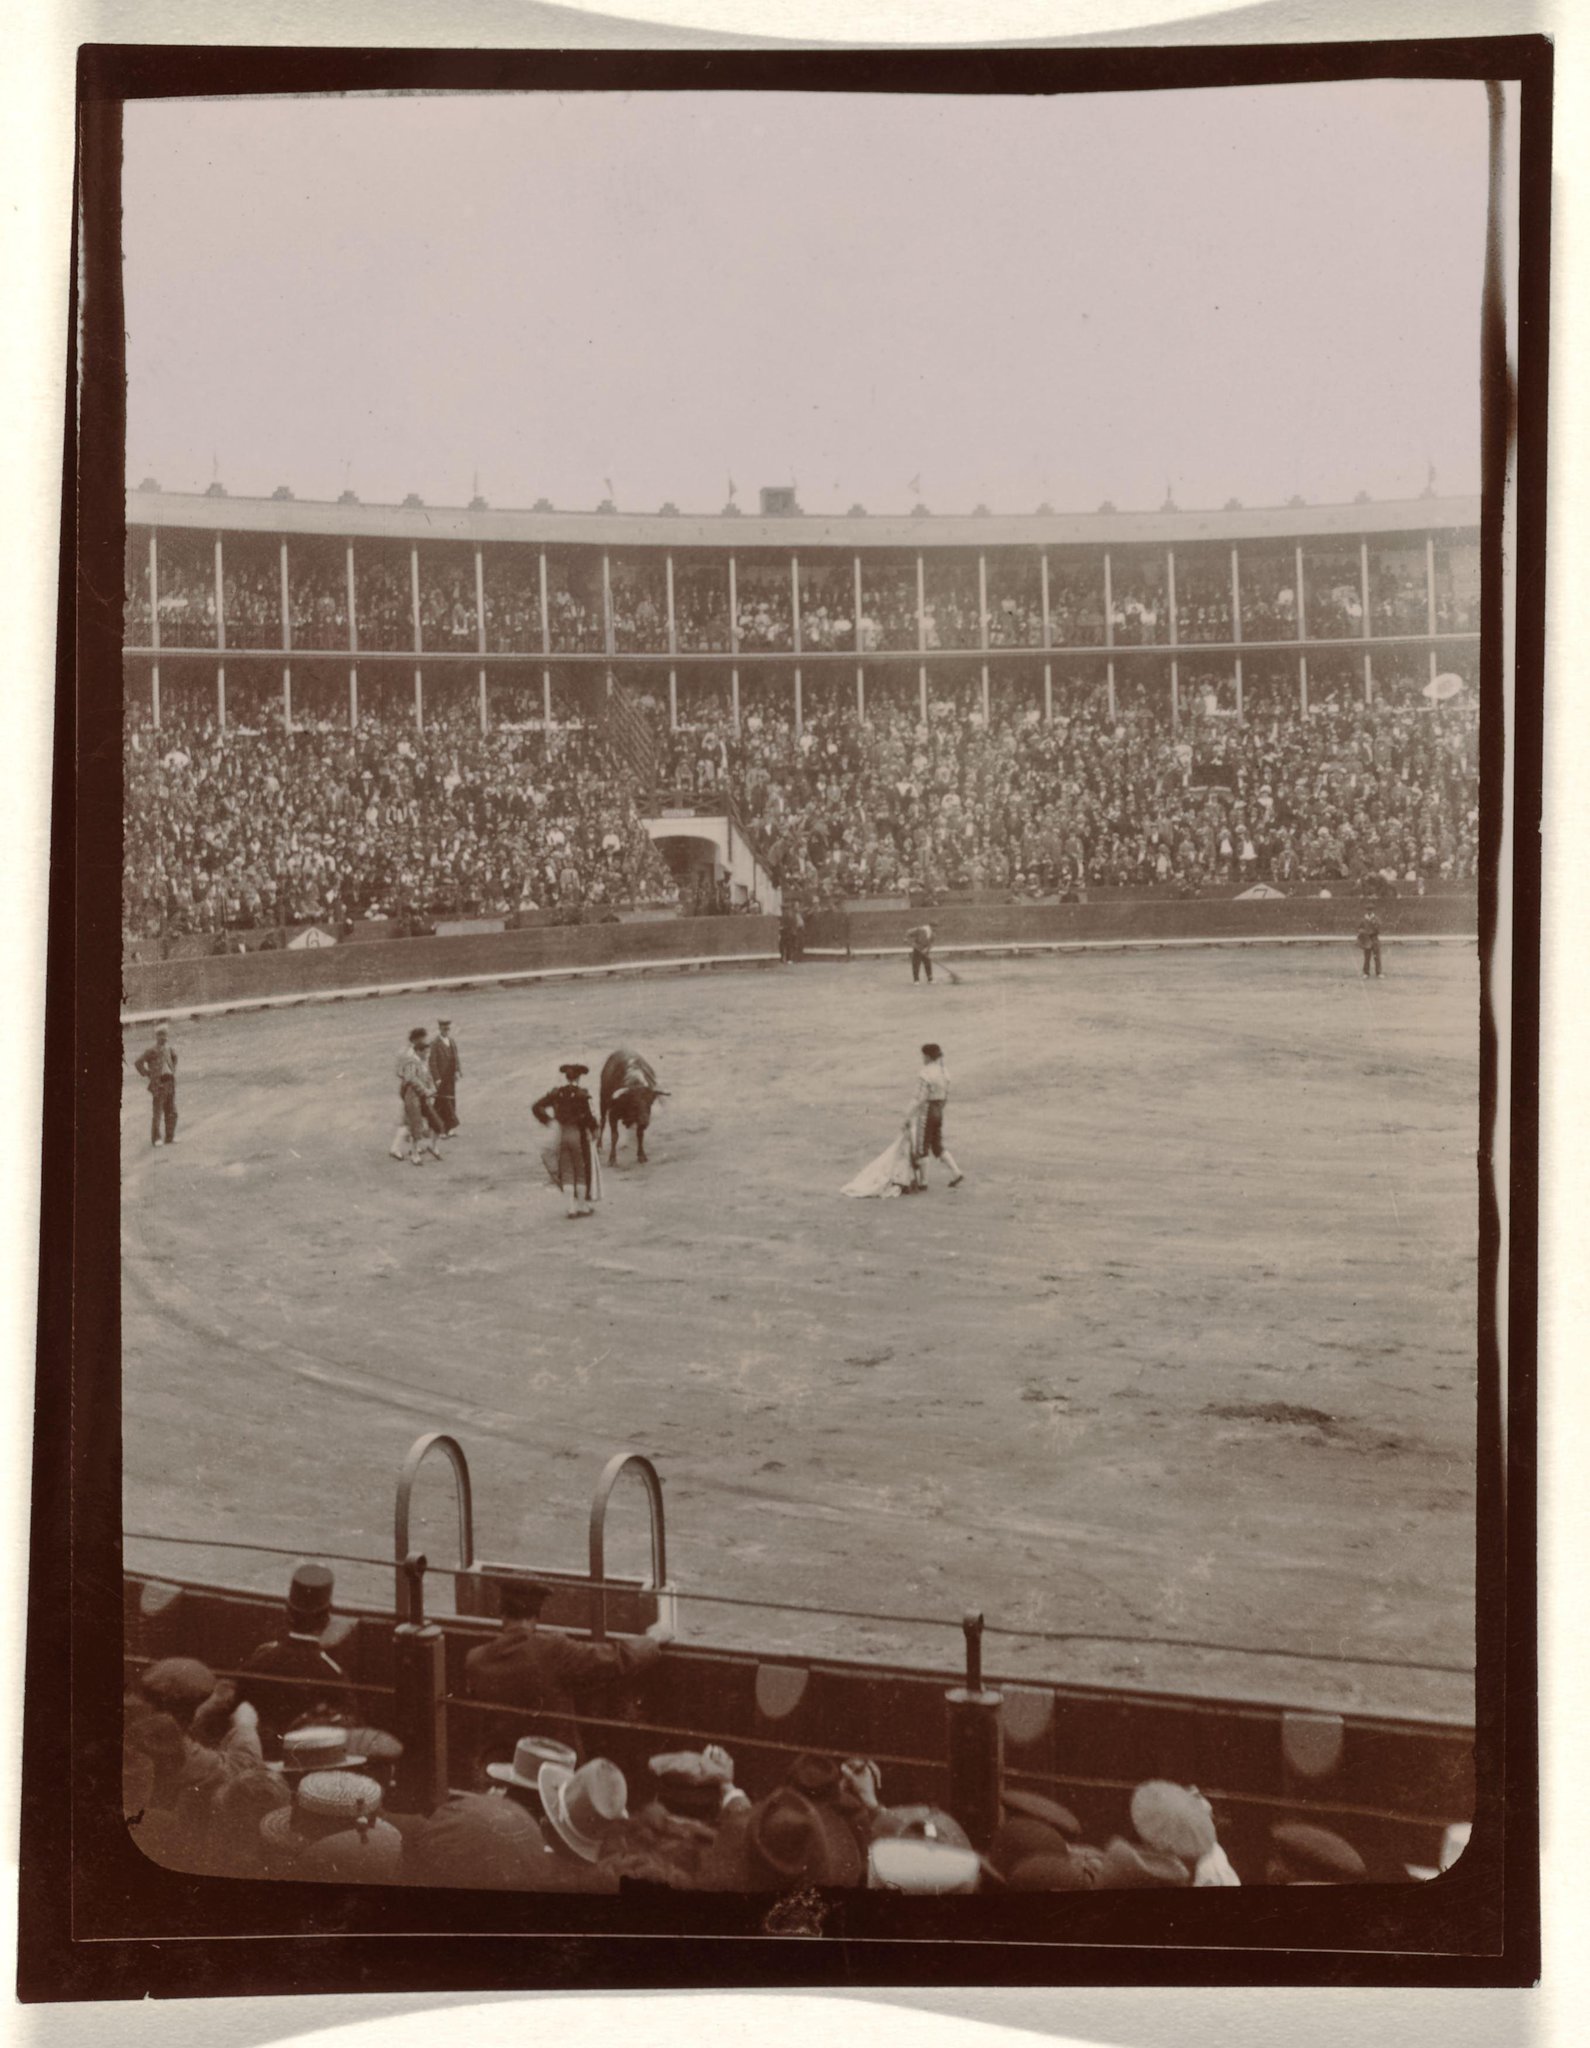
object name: photograph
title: At the Bull Fight, Spain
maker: Anonymous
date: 1905-1922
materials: photographic support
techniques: gelatin silver print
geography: spain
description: Arena voor stierengevechten in Valencia of Barcelona.